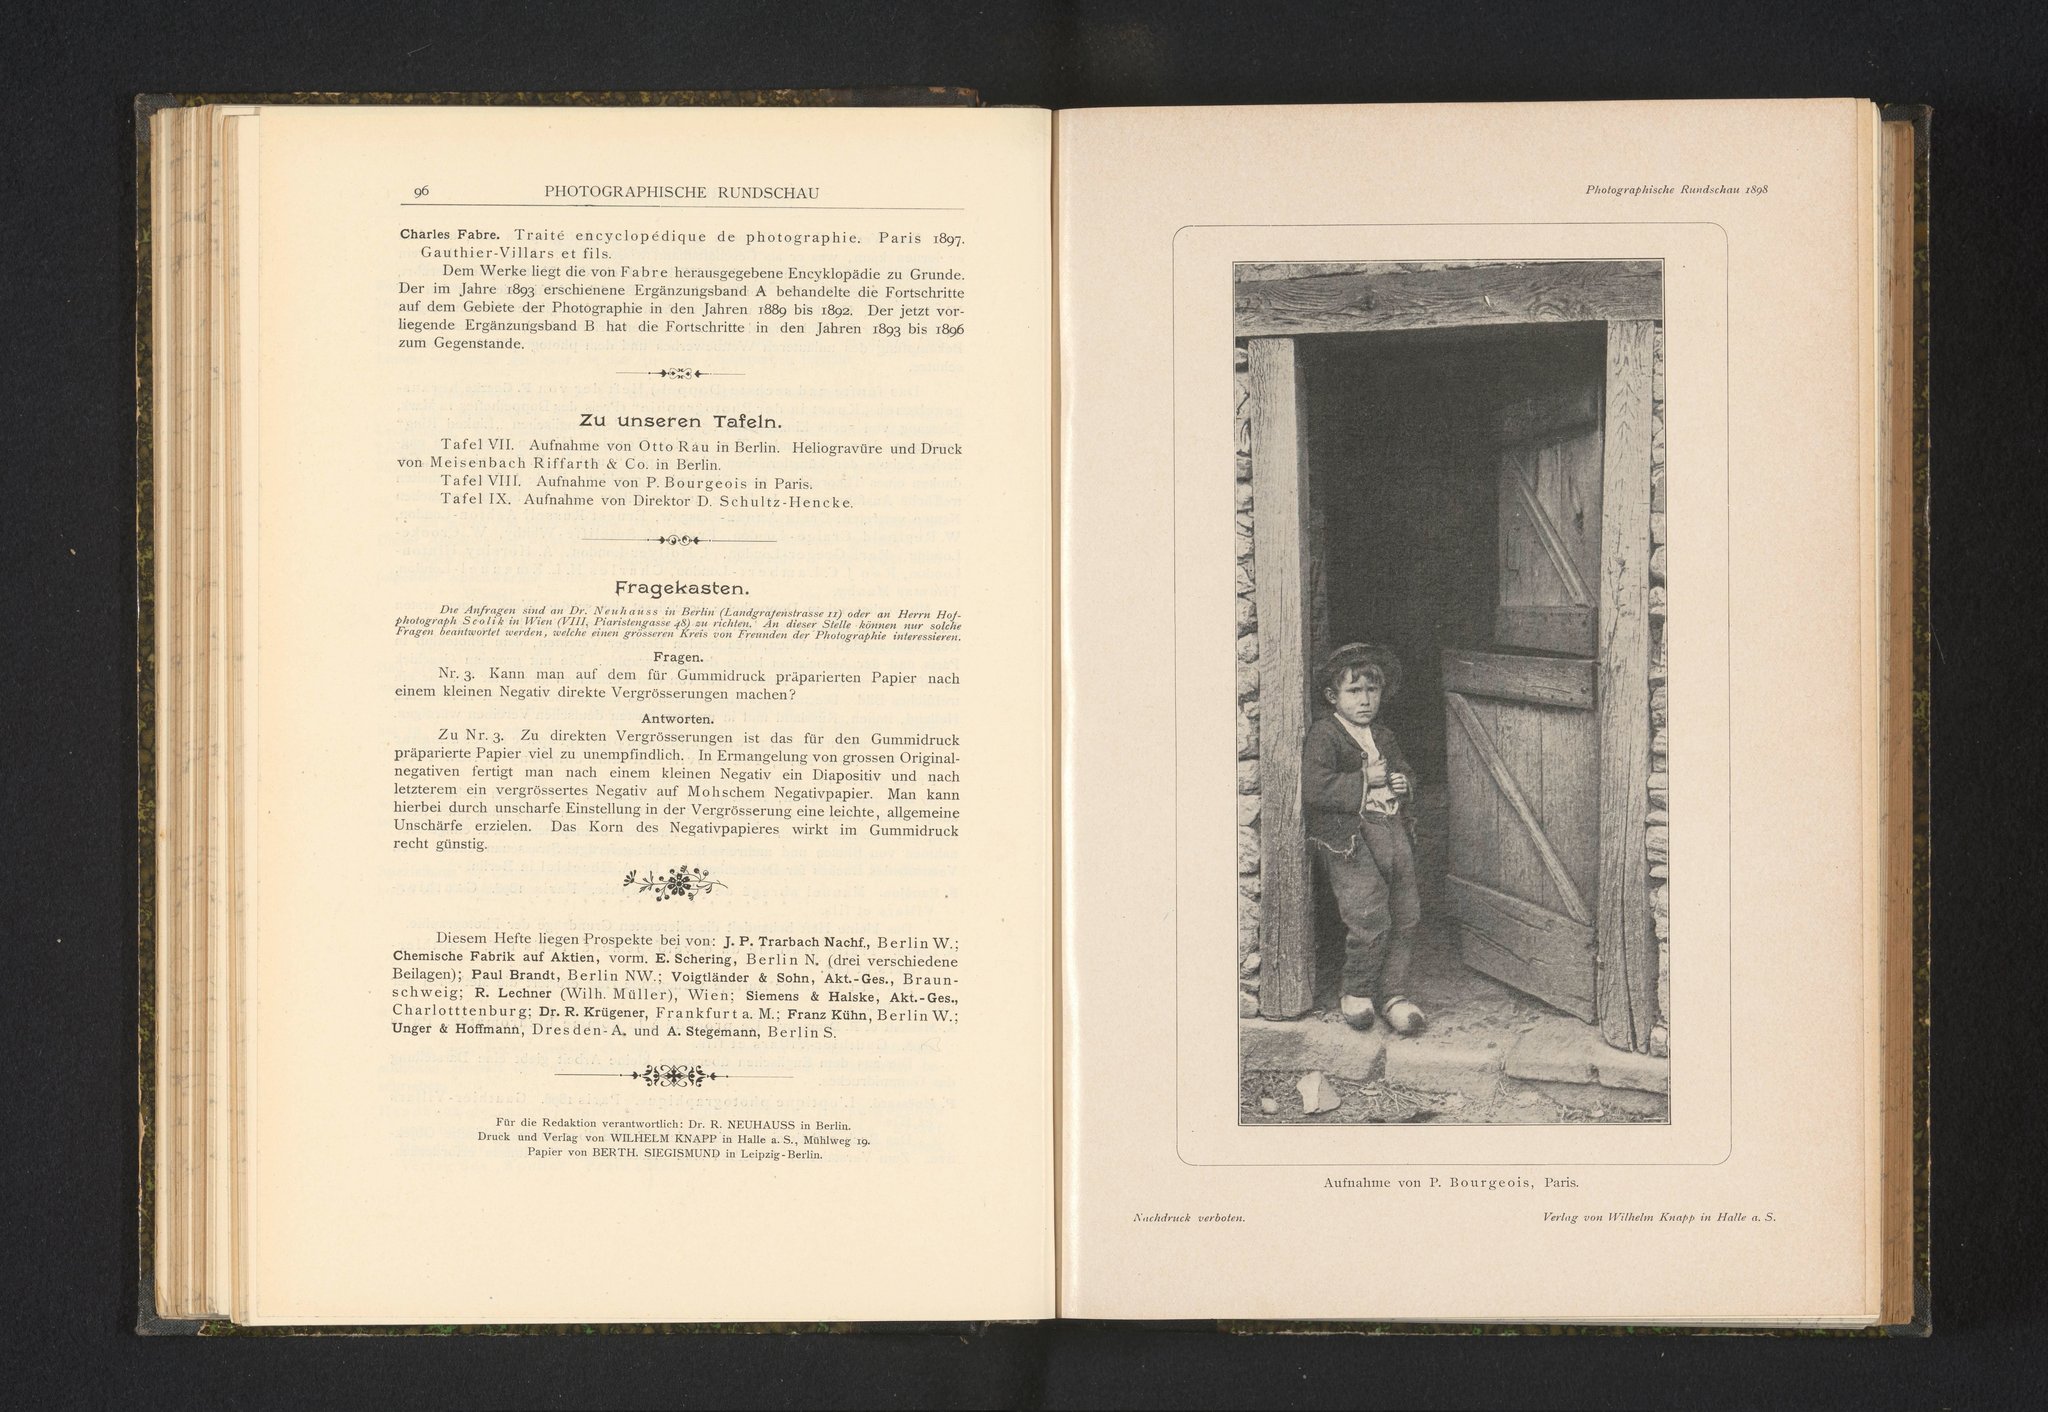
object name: photomechanical print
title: Jongen op klompen in een deuropening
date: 1893-1898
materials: paper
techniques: autotype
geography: paris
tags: open door, boy (child between toddler and youth), wooden shoes, clogs